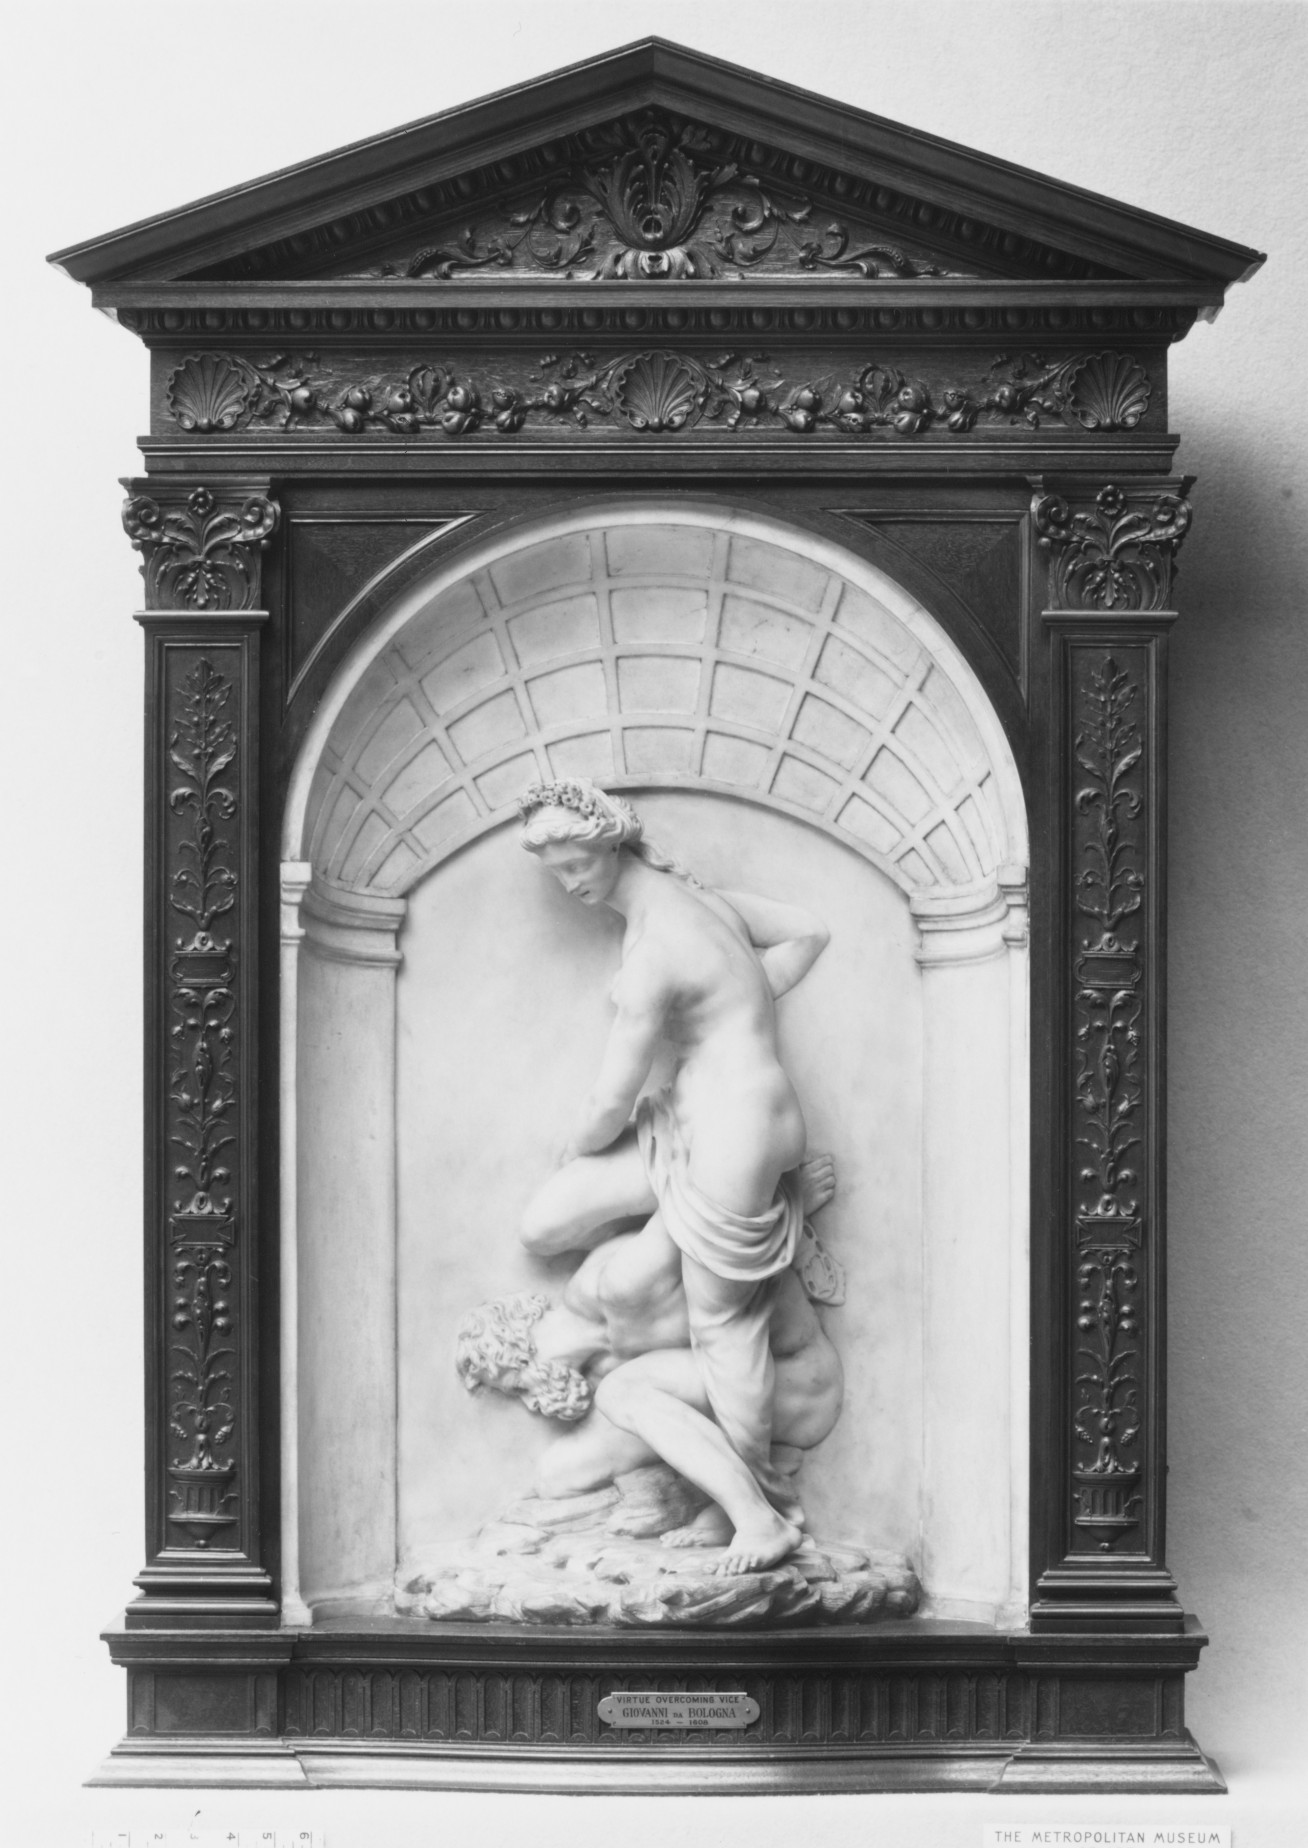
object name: high relief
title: Virtue Overcoming Vice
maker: giambologna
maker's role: artist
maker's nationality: netherlandish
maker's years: 1529-1608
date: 1601-1800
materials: marble, wood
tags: male nudes,female nudes